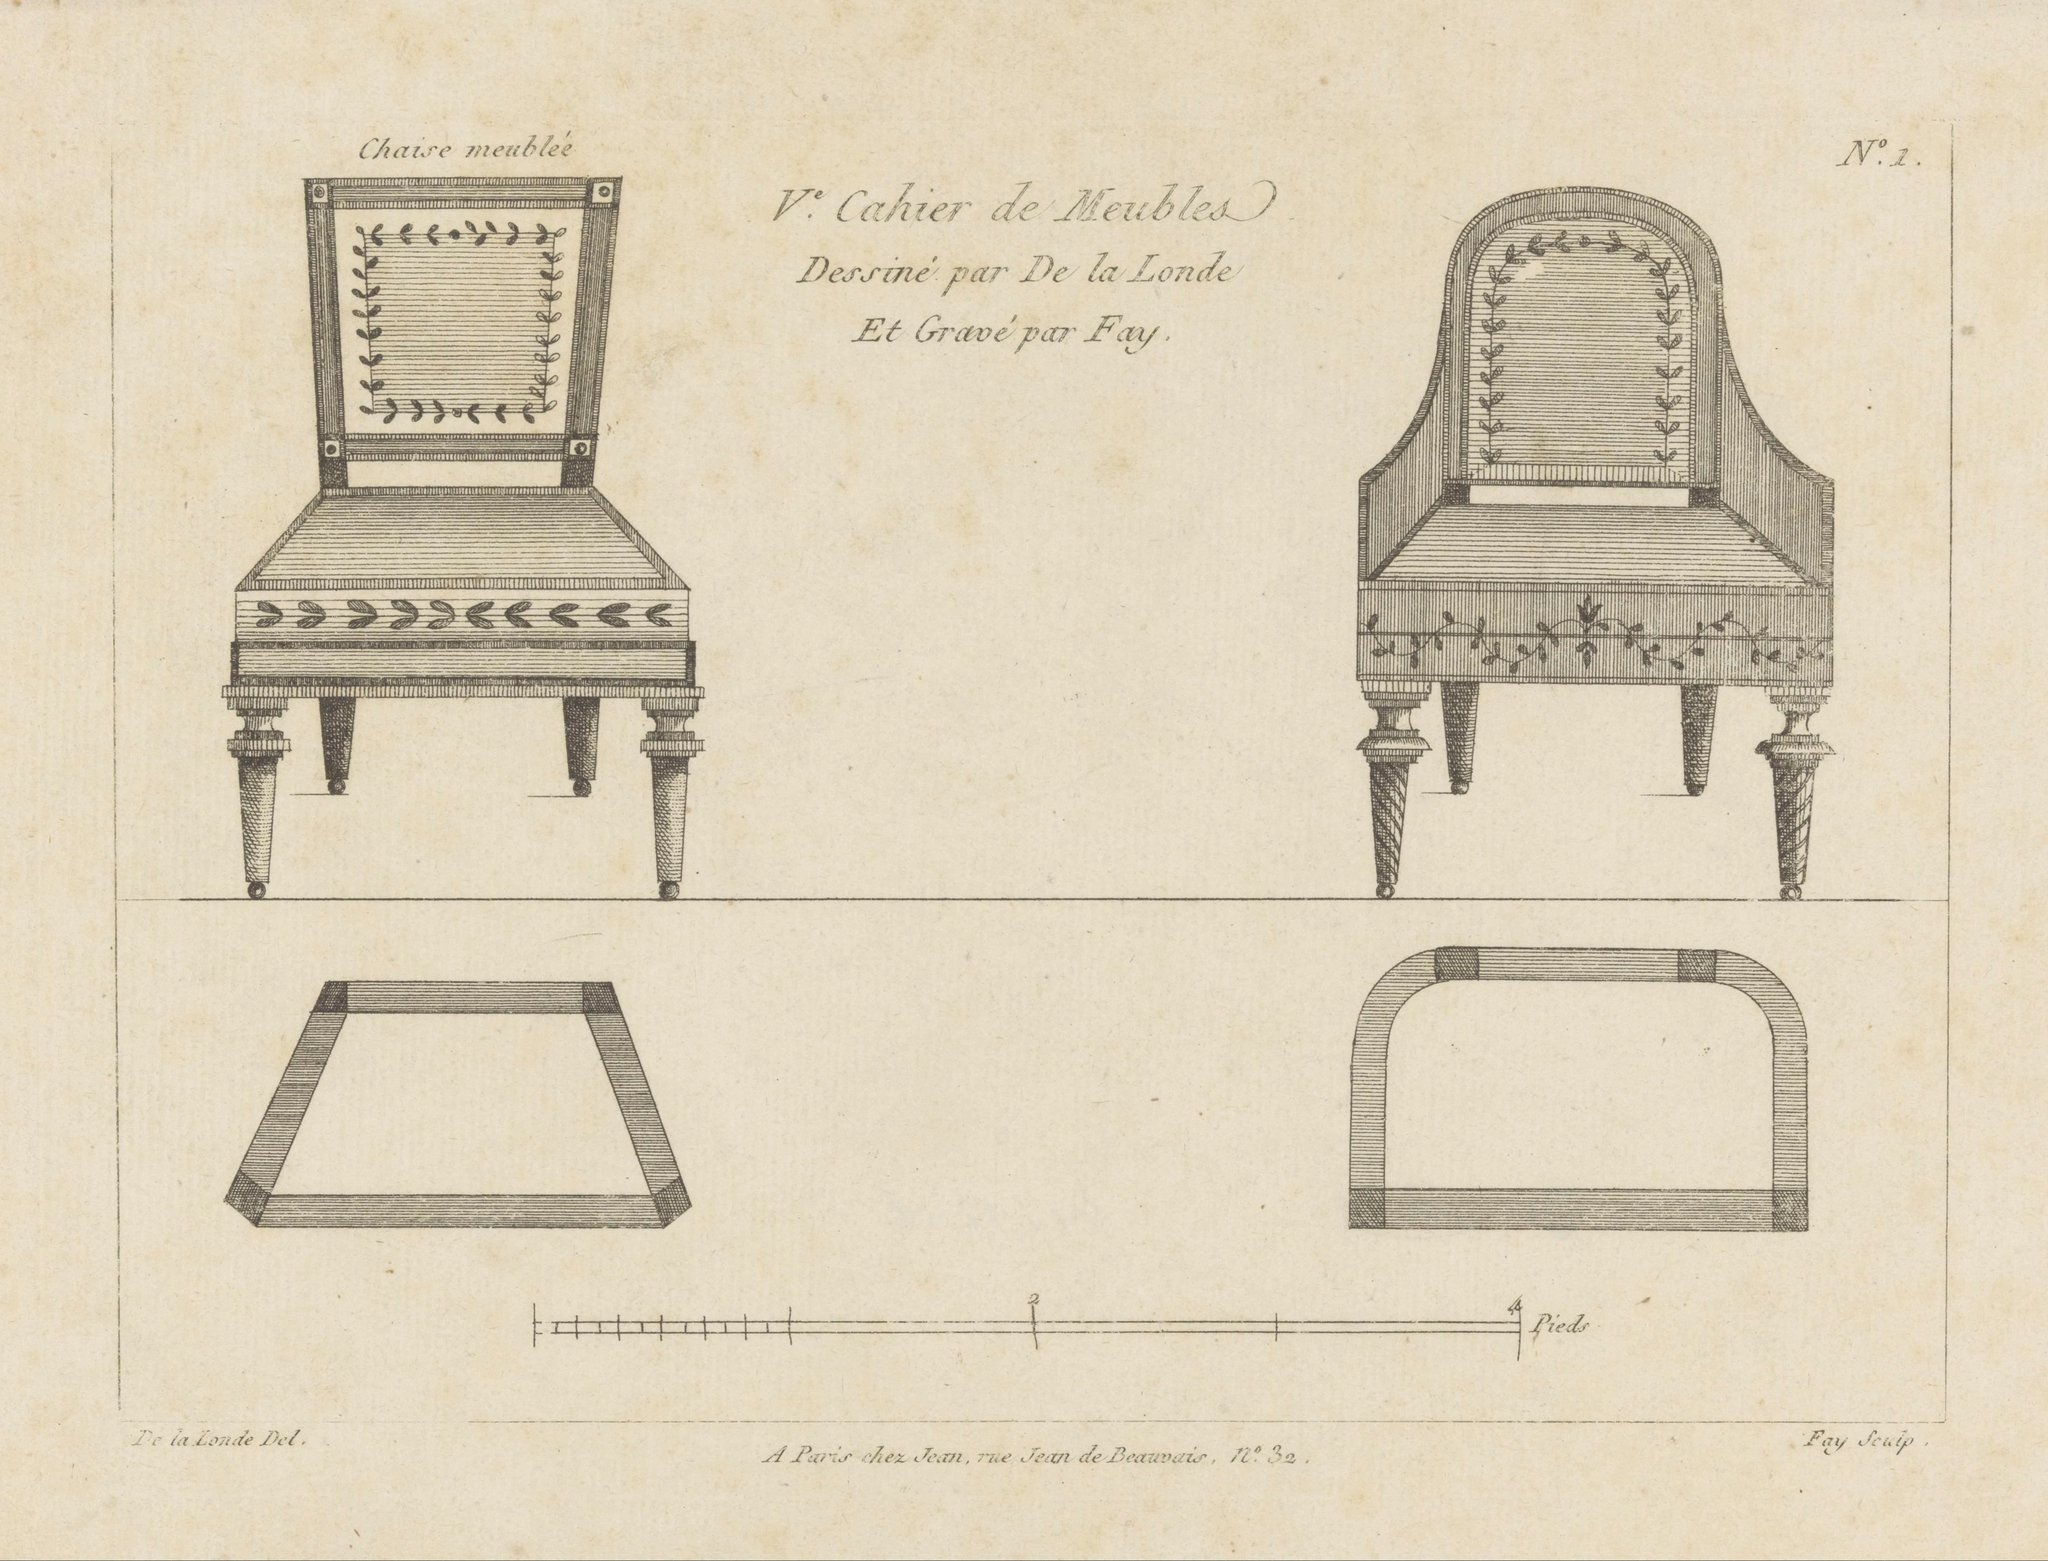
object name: ornament print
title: Ve Cahier de Meubles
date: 1784-1796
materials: paper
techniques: etching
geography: paris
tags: chair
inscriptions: collector's mark: Lugt 2228, collector's mark: Lugt 2760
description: Voor- en bovenaanzichten van twee stoelen met bladmotieven. Links een stoel met een vierkante rugleuning, rechts met een halfronde rugleuning en armleuningen.